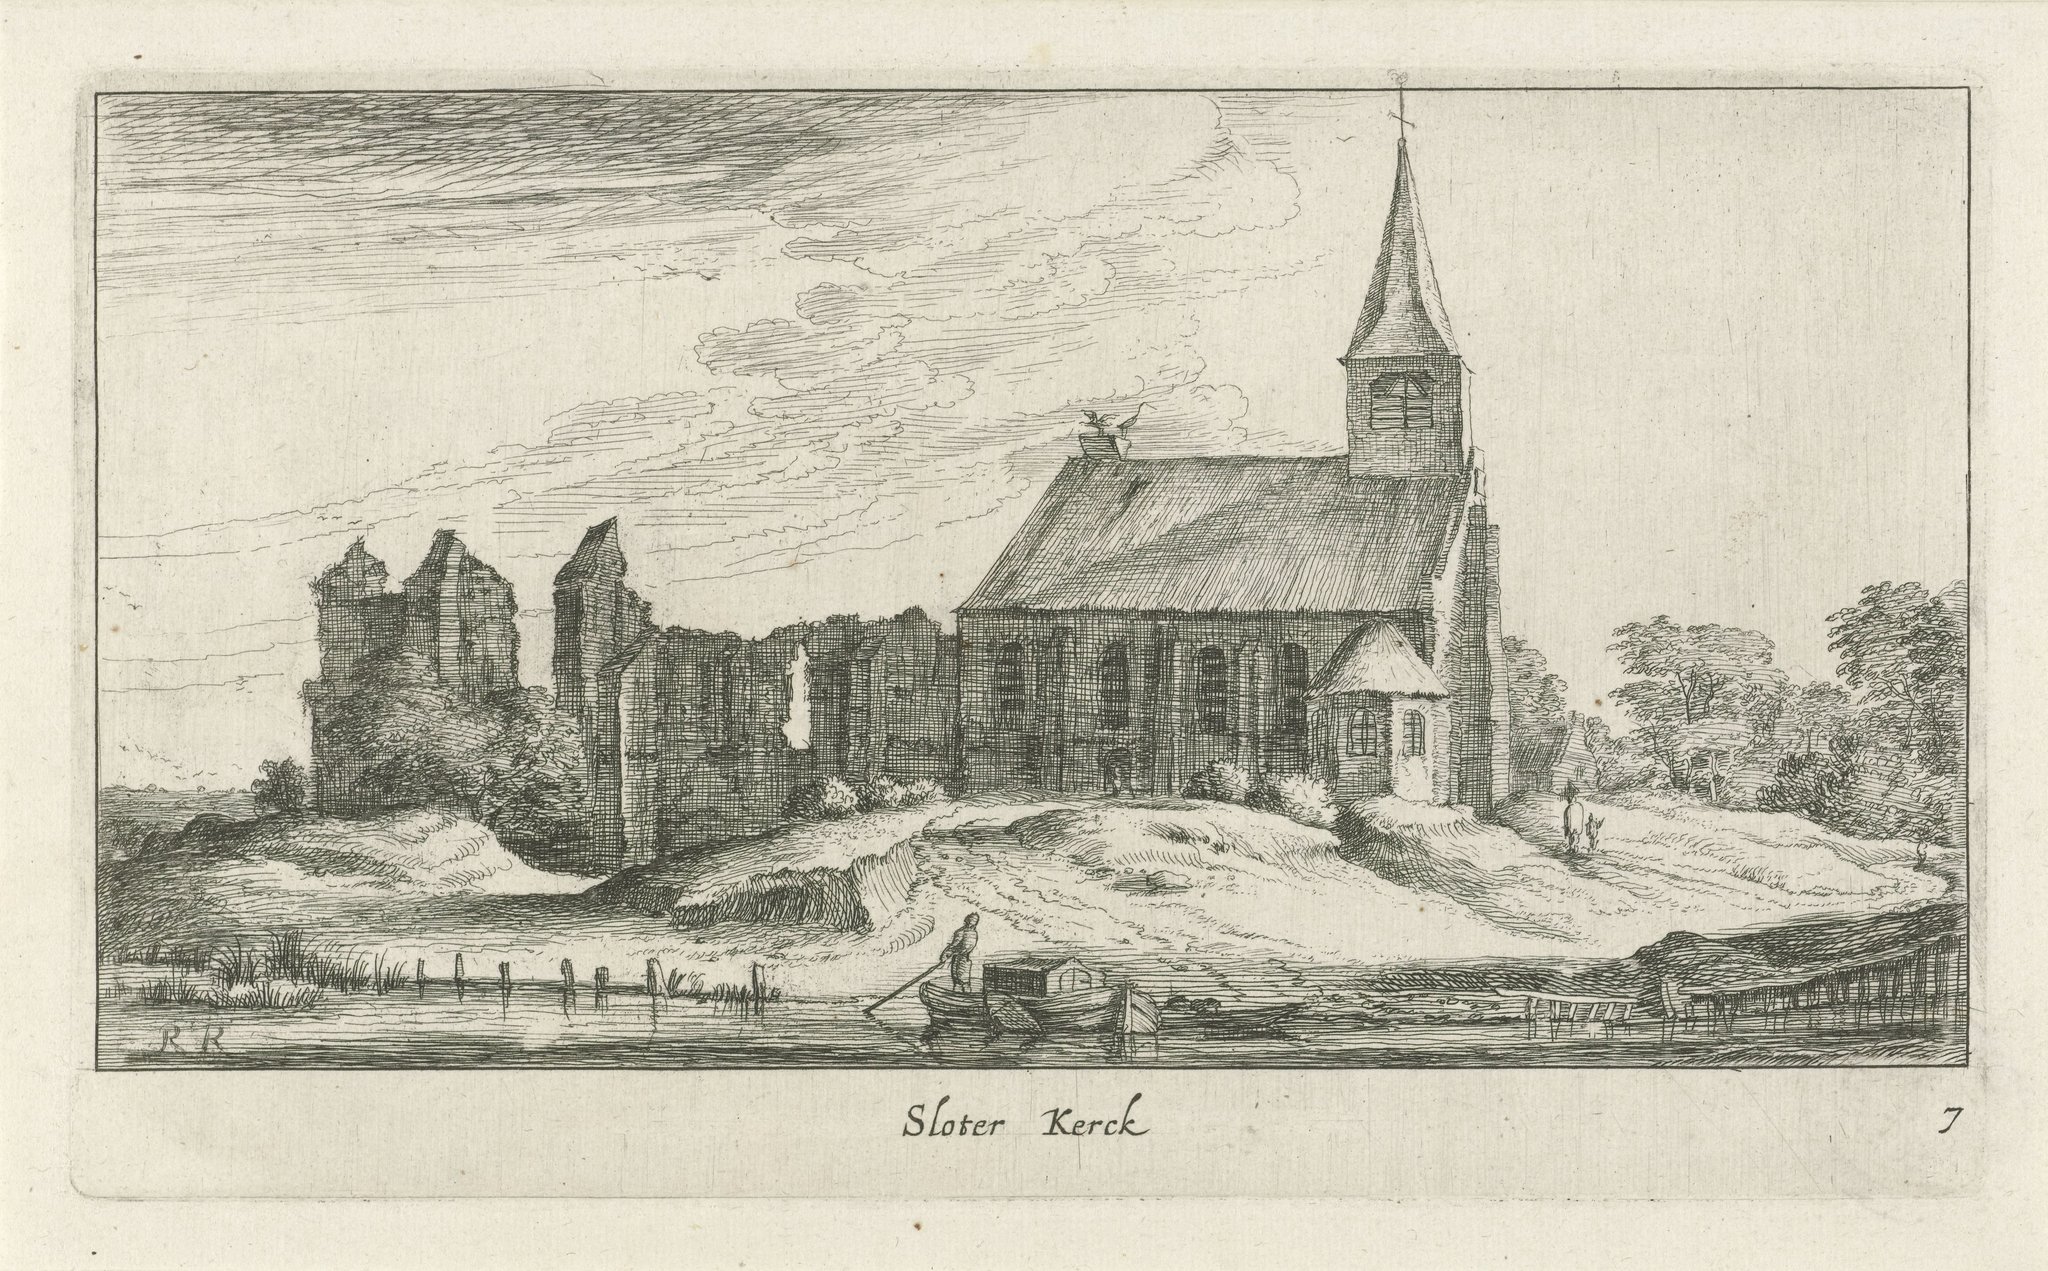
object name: print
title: Sloter Kerck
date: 1637-1652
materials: paper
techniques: engraving, etching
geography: amsterdam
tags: shore-birds and wading-birds: stork, church (exterior), ruin of church, monastery, etc.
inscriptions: collector's mark: Lugt 240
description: Gezicht op de nieuwe Sloterkerk en het verwoeste koor van de oude kerk, vanuit het noorden. Op het dak van de kerk een ooievaarsnest. De prent is deel van een serie landschappen met dorpen rondom Amsterdam. Rechtsonder genummerd: 7.